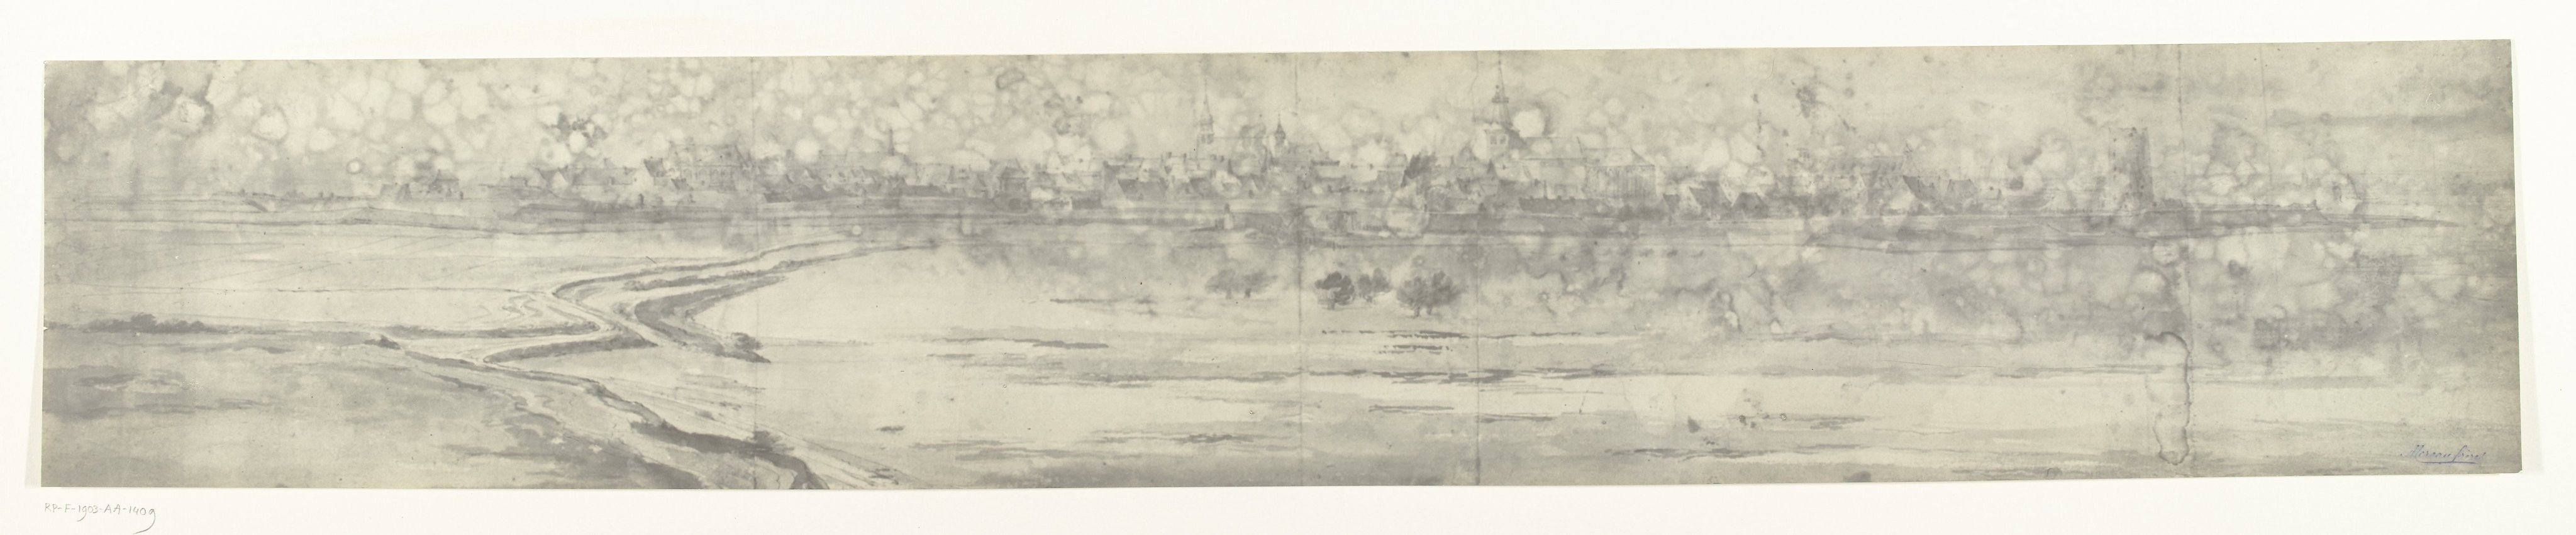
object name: photograph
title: Gezicht op Rheinberg, 1672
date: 1900-1903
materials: paper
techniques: gelatin silver print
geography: france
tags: lodewijk xiv (koning van frankrijk), prospect of city, town panorama, silhouette of city, rampjaar (disaster year)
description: Niet in Frederik Muller; door het RPK toegevoegd nummer. Onderdeel van een groep van ca. 50 foto's van tekeningen van de Franse inval in de Nederlanden in 1672 door Adam Frans van der Meulen, bewaard in de Manufacture Nationale des Gobelins te Parijs.